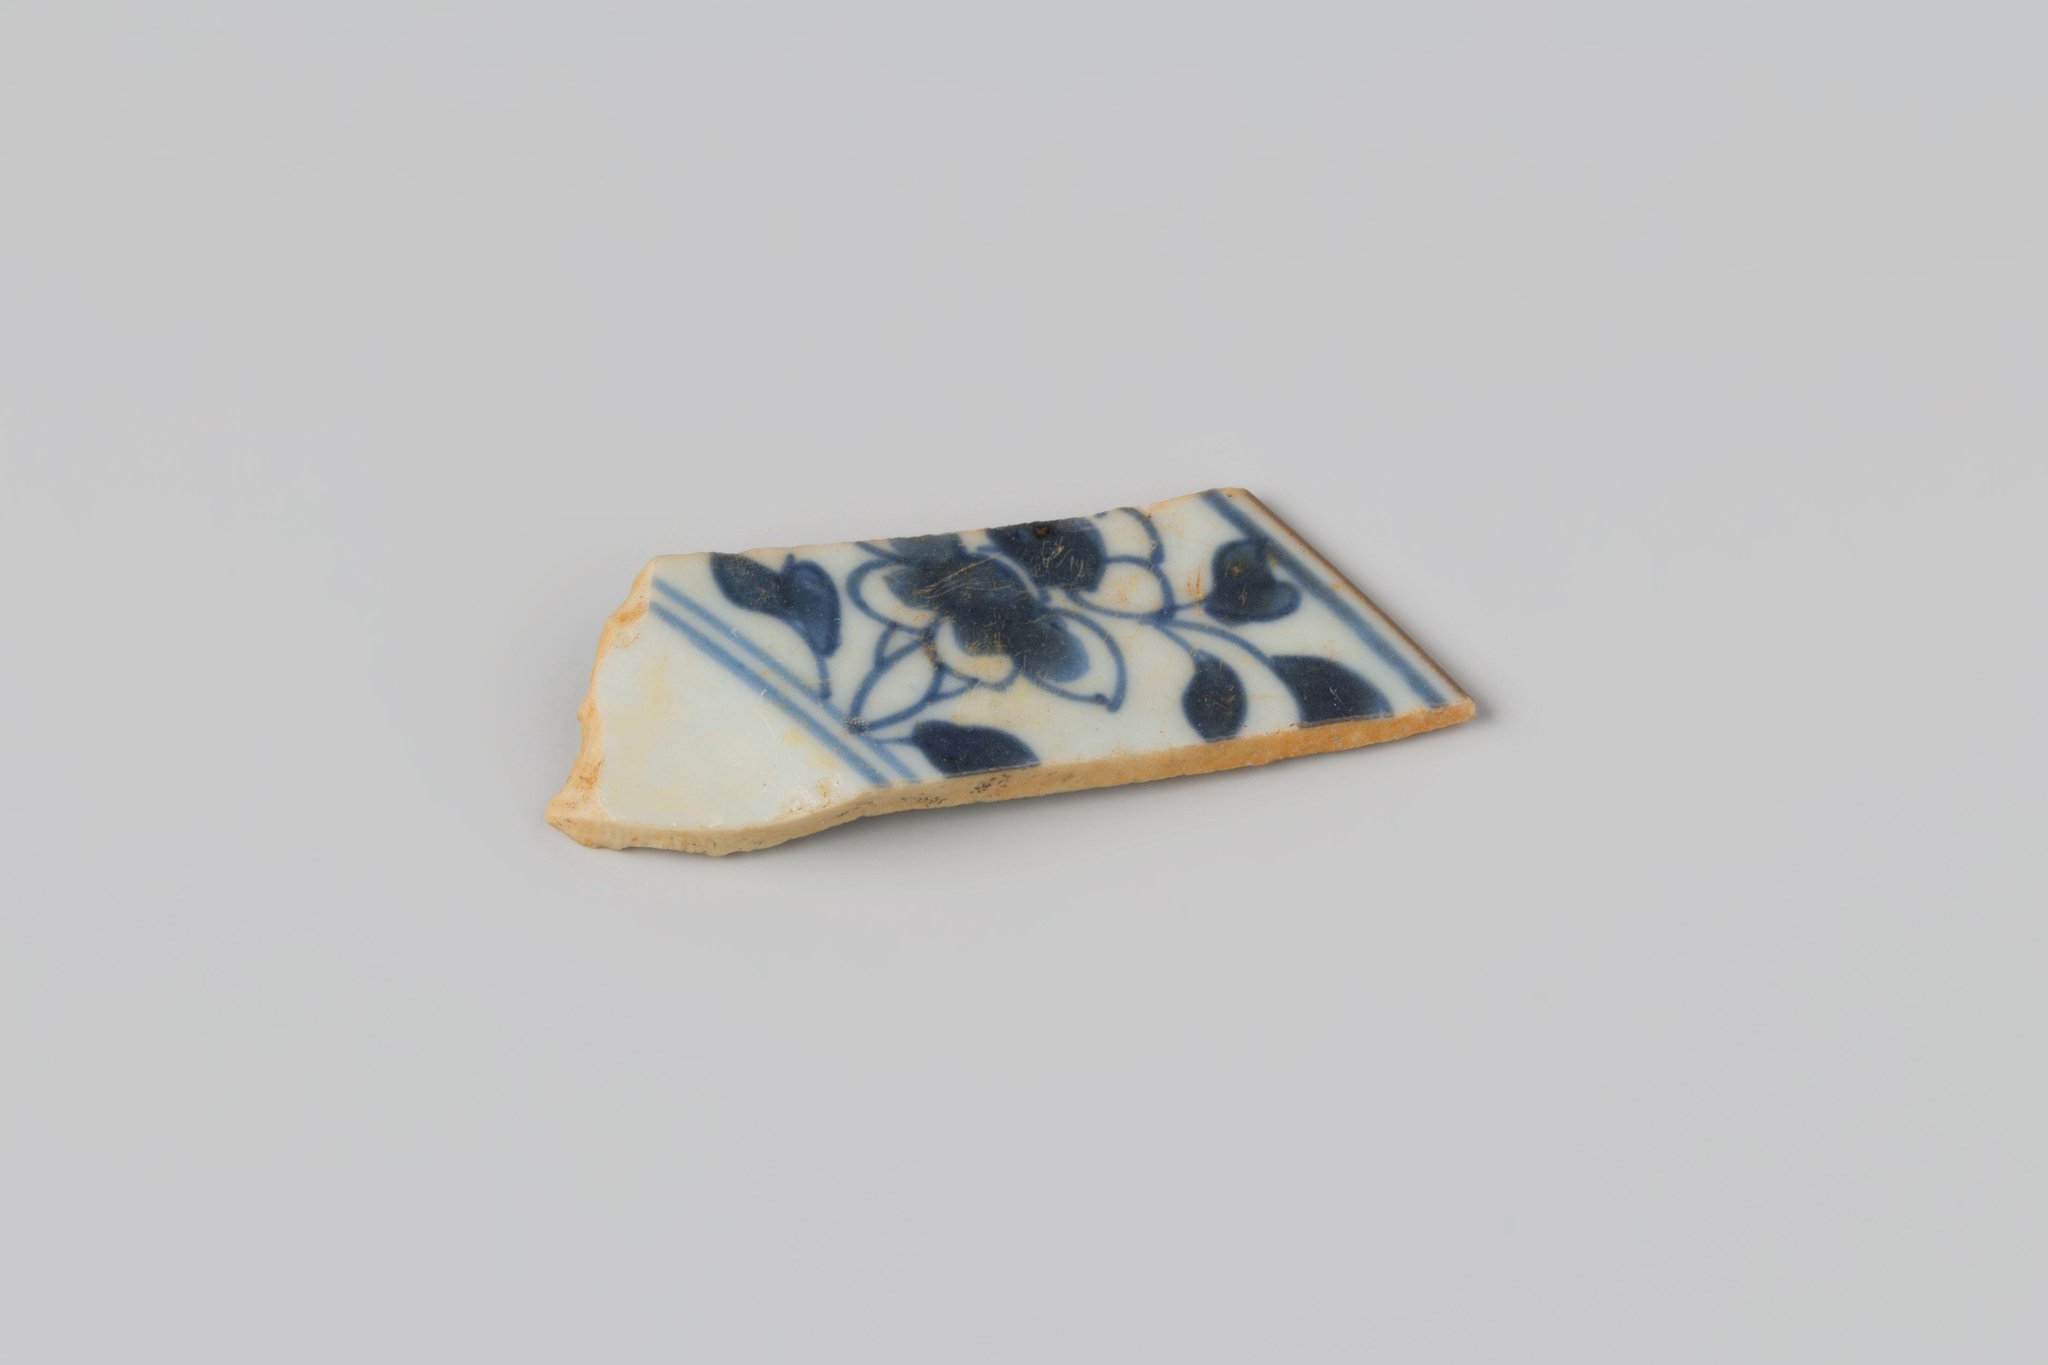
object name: sherd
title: Scherf van een bord uit het wrak van de Oost-Indiëvaarder Hollandia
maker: Anonymous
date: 1700-1743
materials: porcelain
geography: netherlands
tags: verenigde oostindische compagnie, hollandia (schip), annet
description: Porcelain, plate, type 3; fragm of rim, sim. NG 1980-27H3202c.